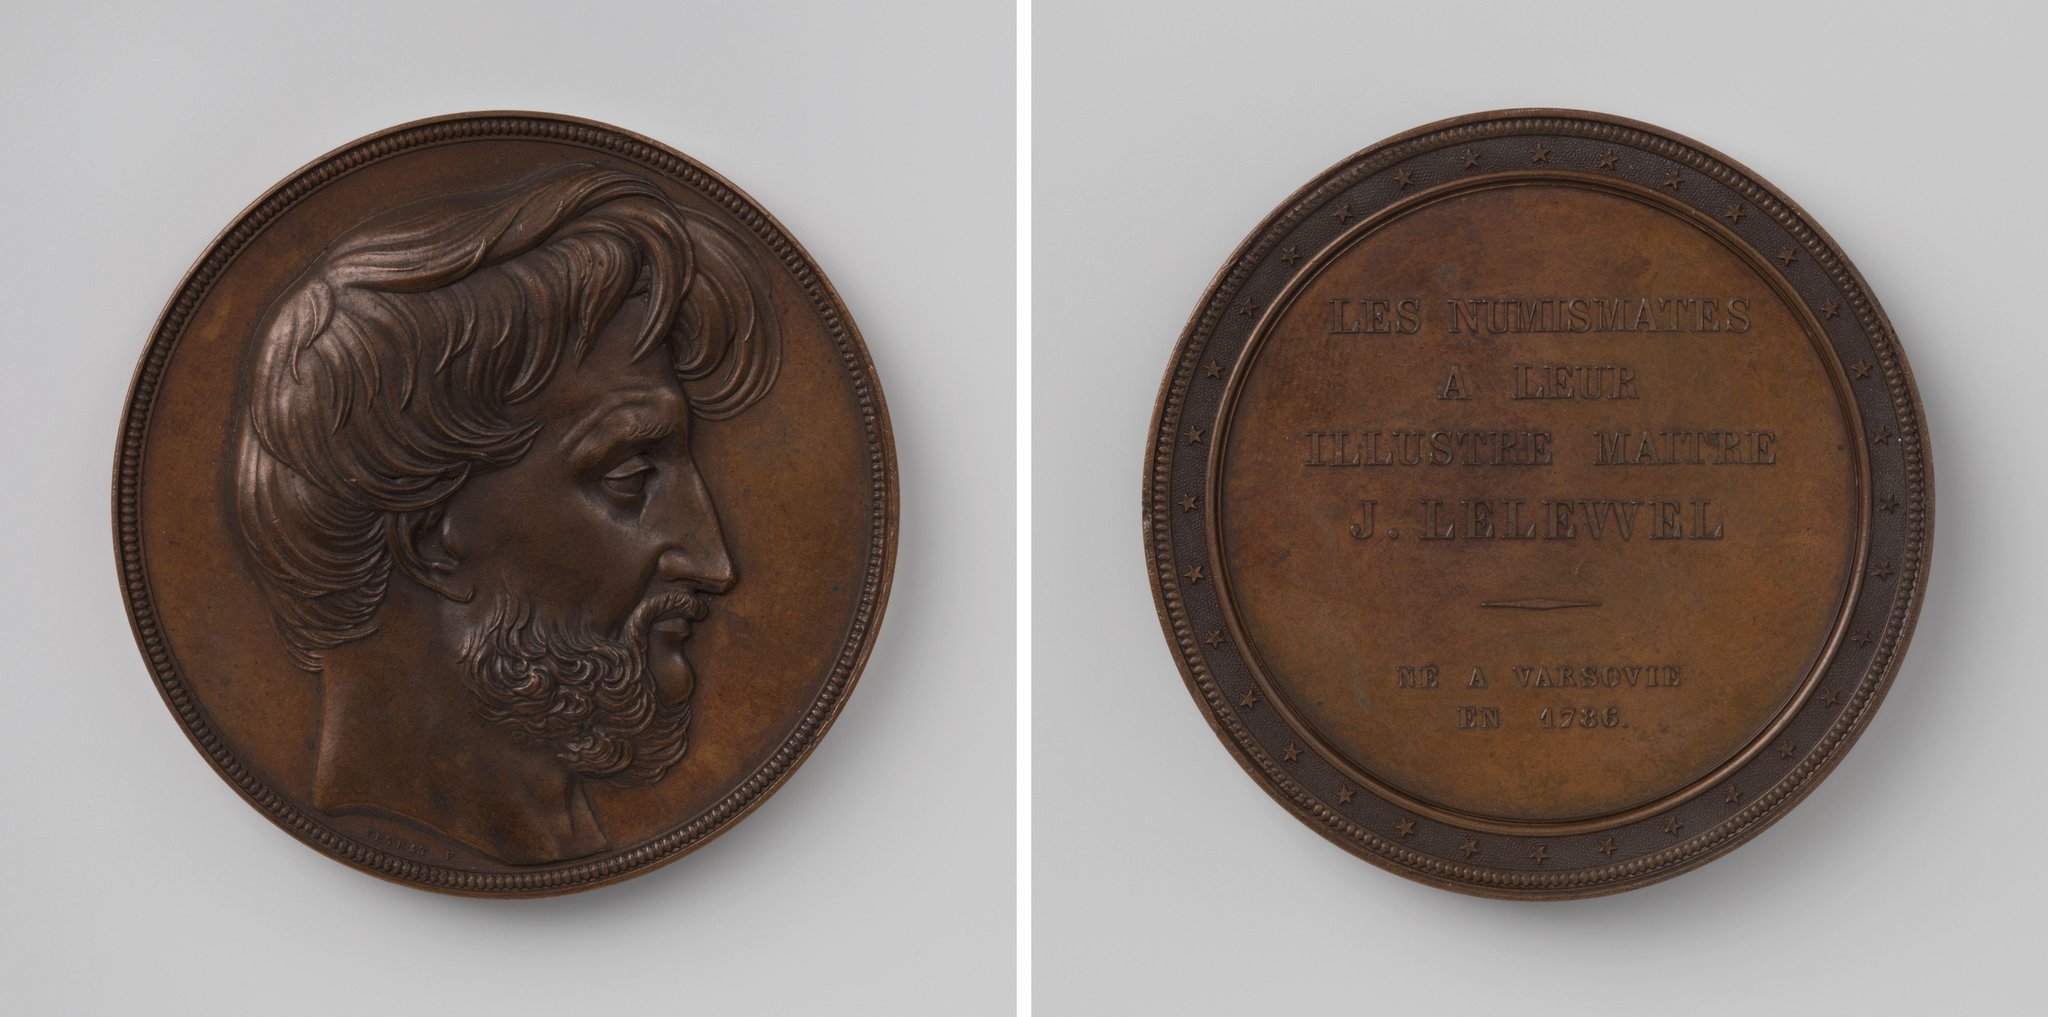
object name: honorary medal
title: Joachim Ignavy Lelewel, archeoloog en penningkundige, penning geslagen op last van de penningkundigen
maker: adrien hippolyte veyrat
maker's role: medailleur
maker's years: 1803-1883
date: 1841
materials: bronze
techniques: striking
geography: brussels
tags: joachim ignavy lelewel, warschau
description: Bronzen penning. Voorzijde: borststuk man. Keerzijde: opschrift binnen rand van sterren